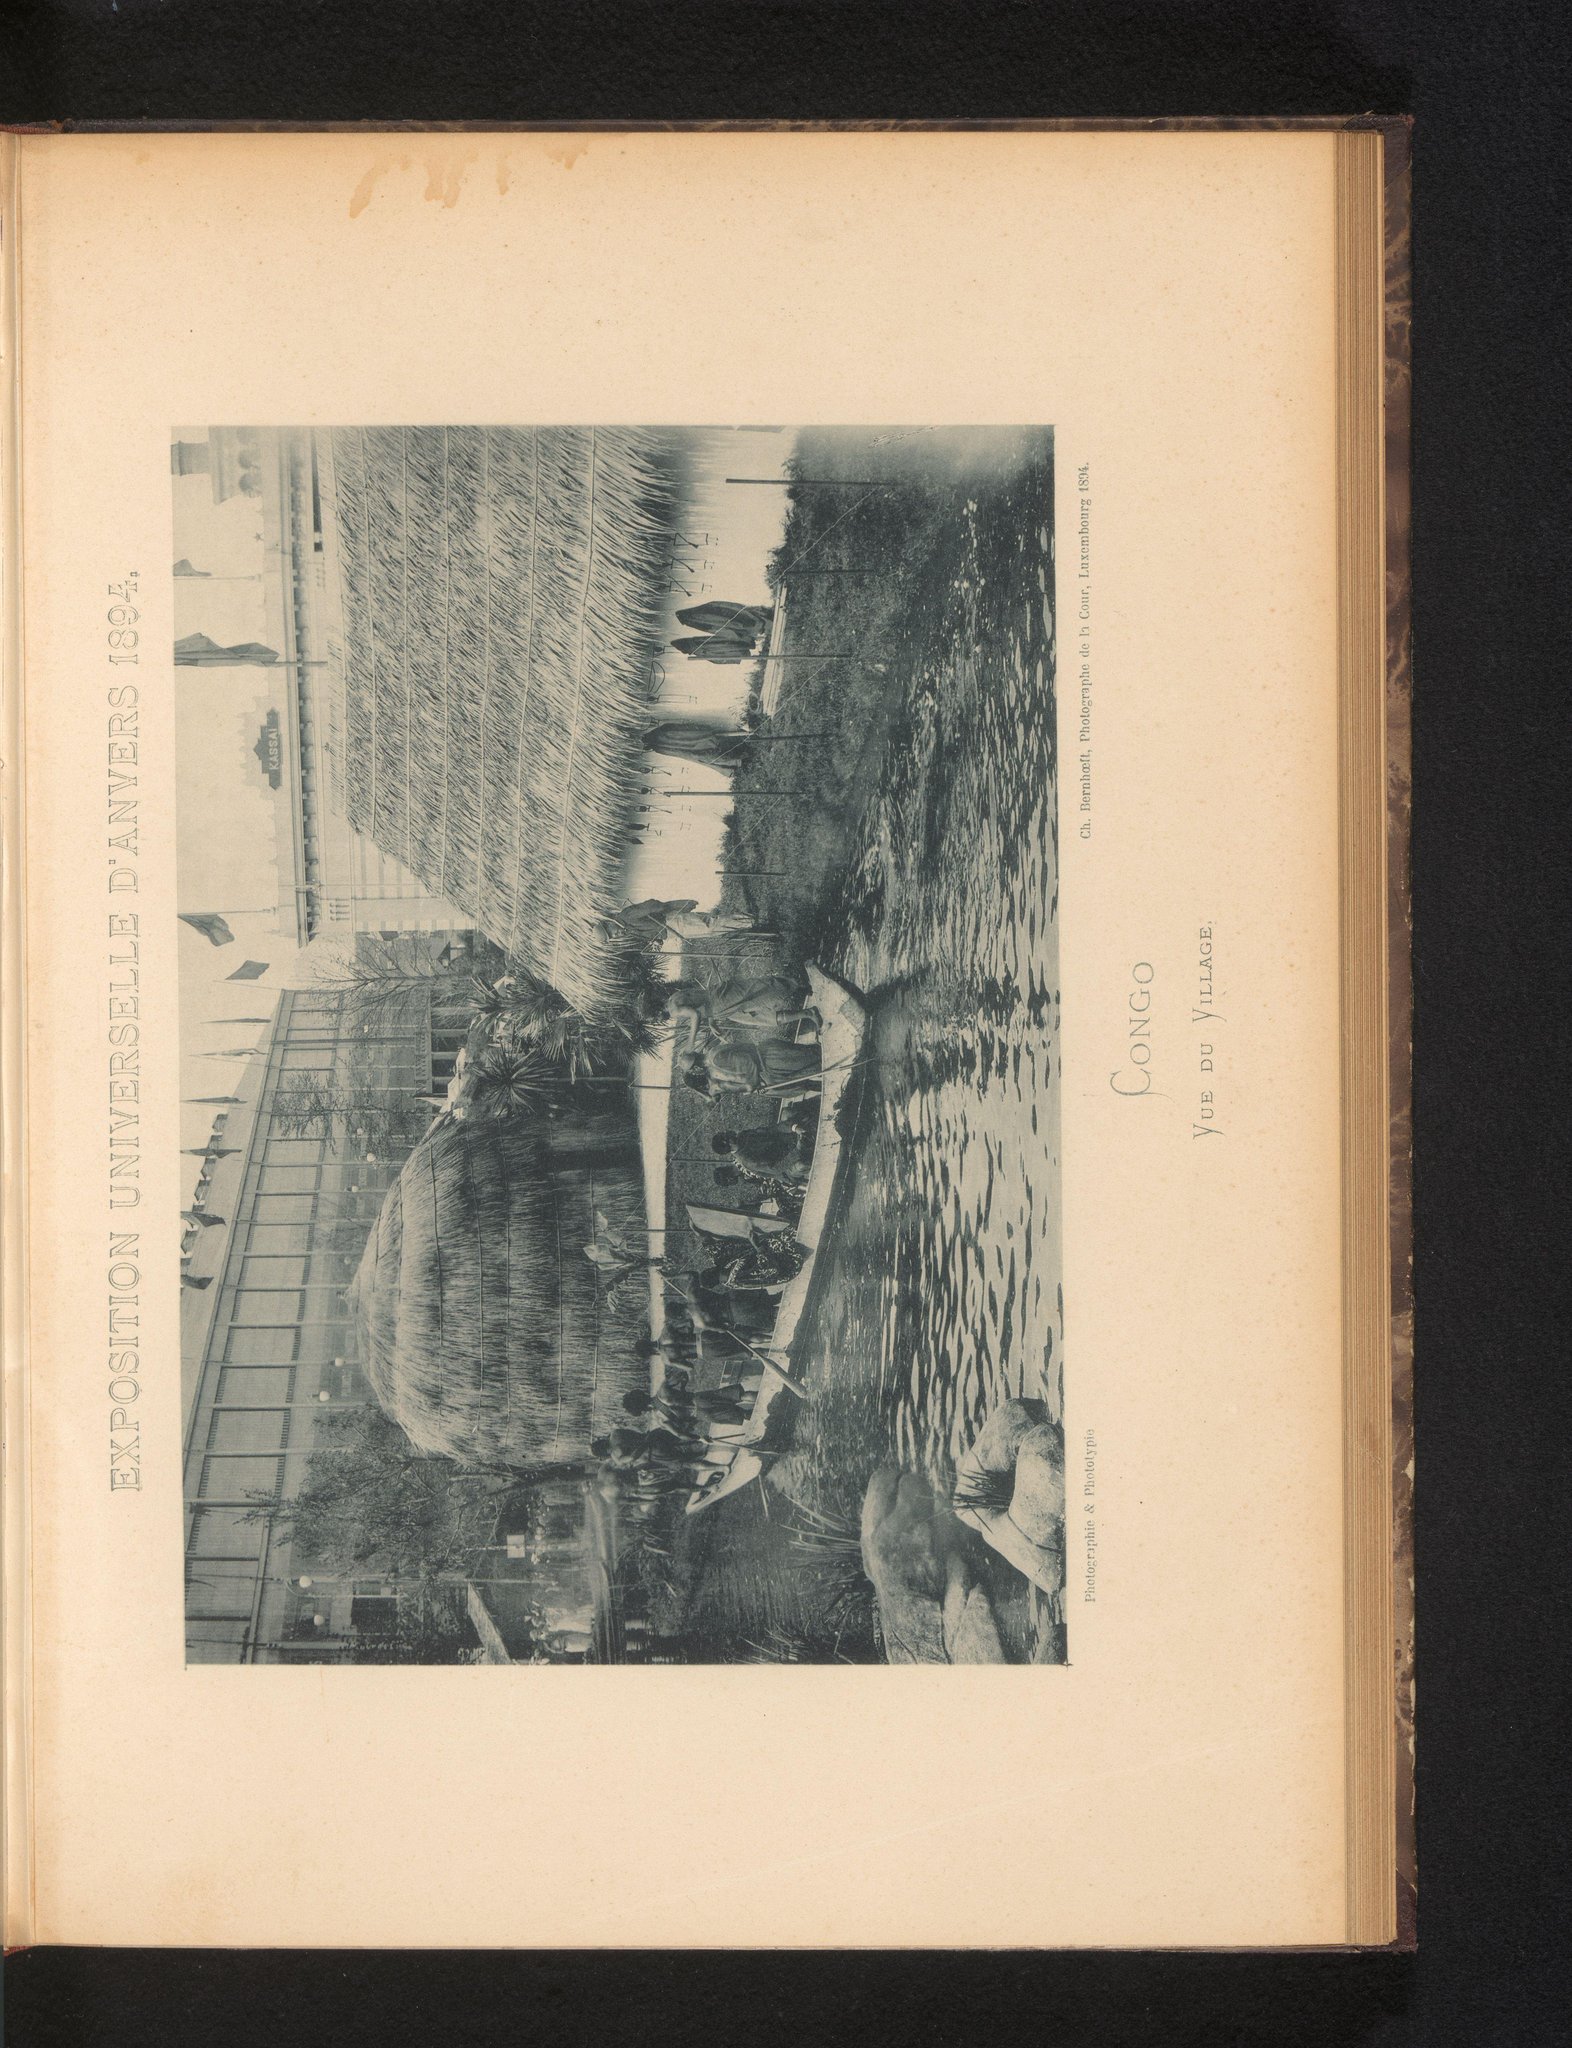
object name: page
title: Mannen in een roeiboot in een nagebouwd Congolees dorp op de Wereldtentoonstelling van Antwerpen in 1894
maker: charles bernhoeft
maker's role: publisher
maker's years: 1859-1933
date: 1894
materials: paper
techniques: photograph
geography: luxembourg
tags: prospect of village, silhouette of village, rowing-boat, canoe, etc. (+ four persons or more ~ traffic and transport), world fair, world exhibition, adult man, antwerp